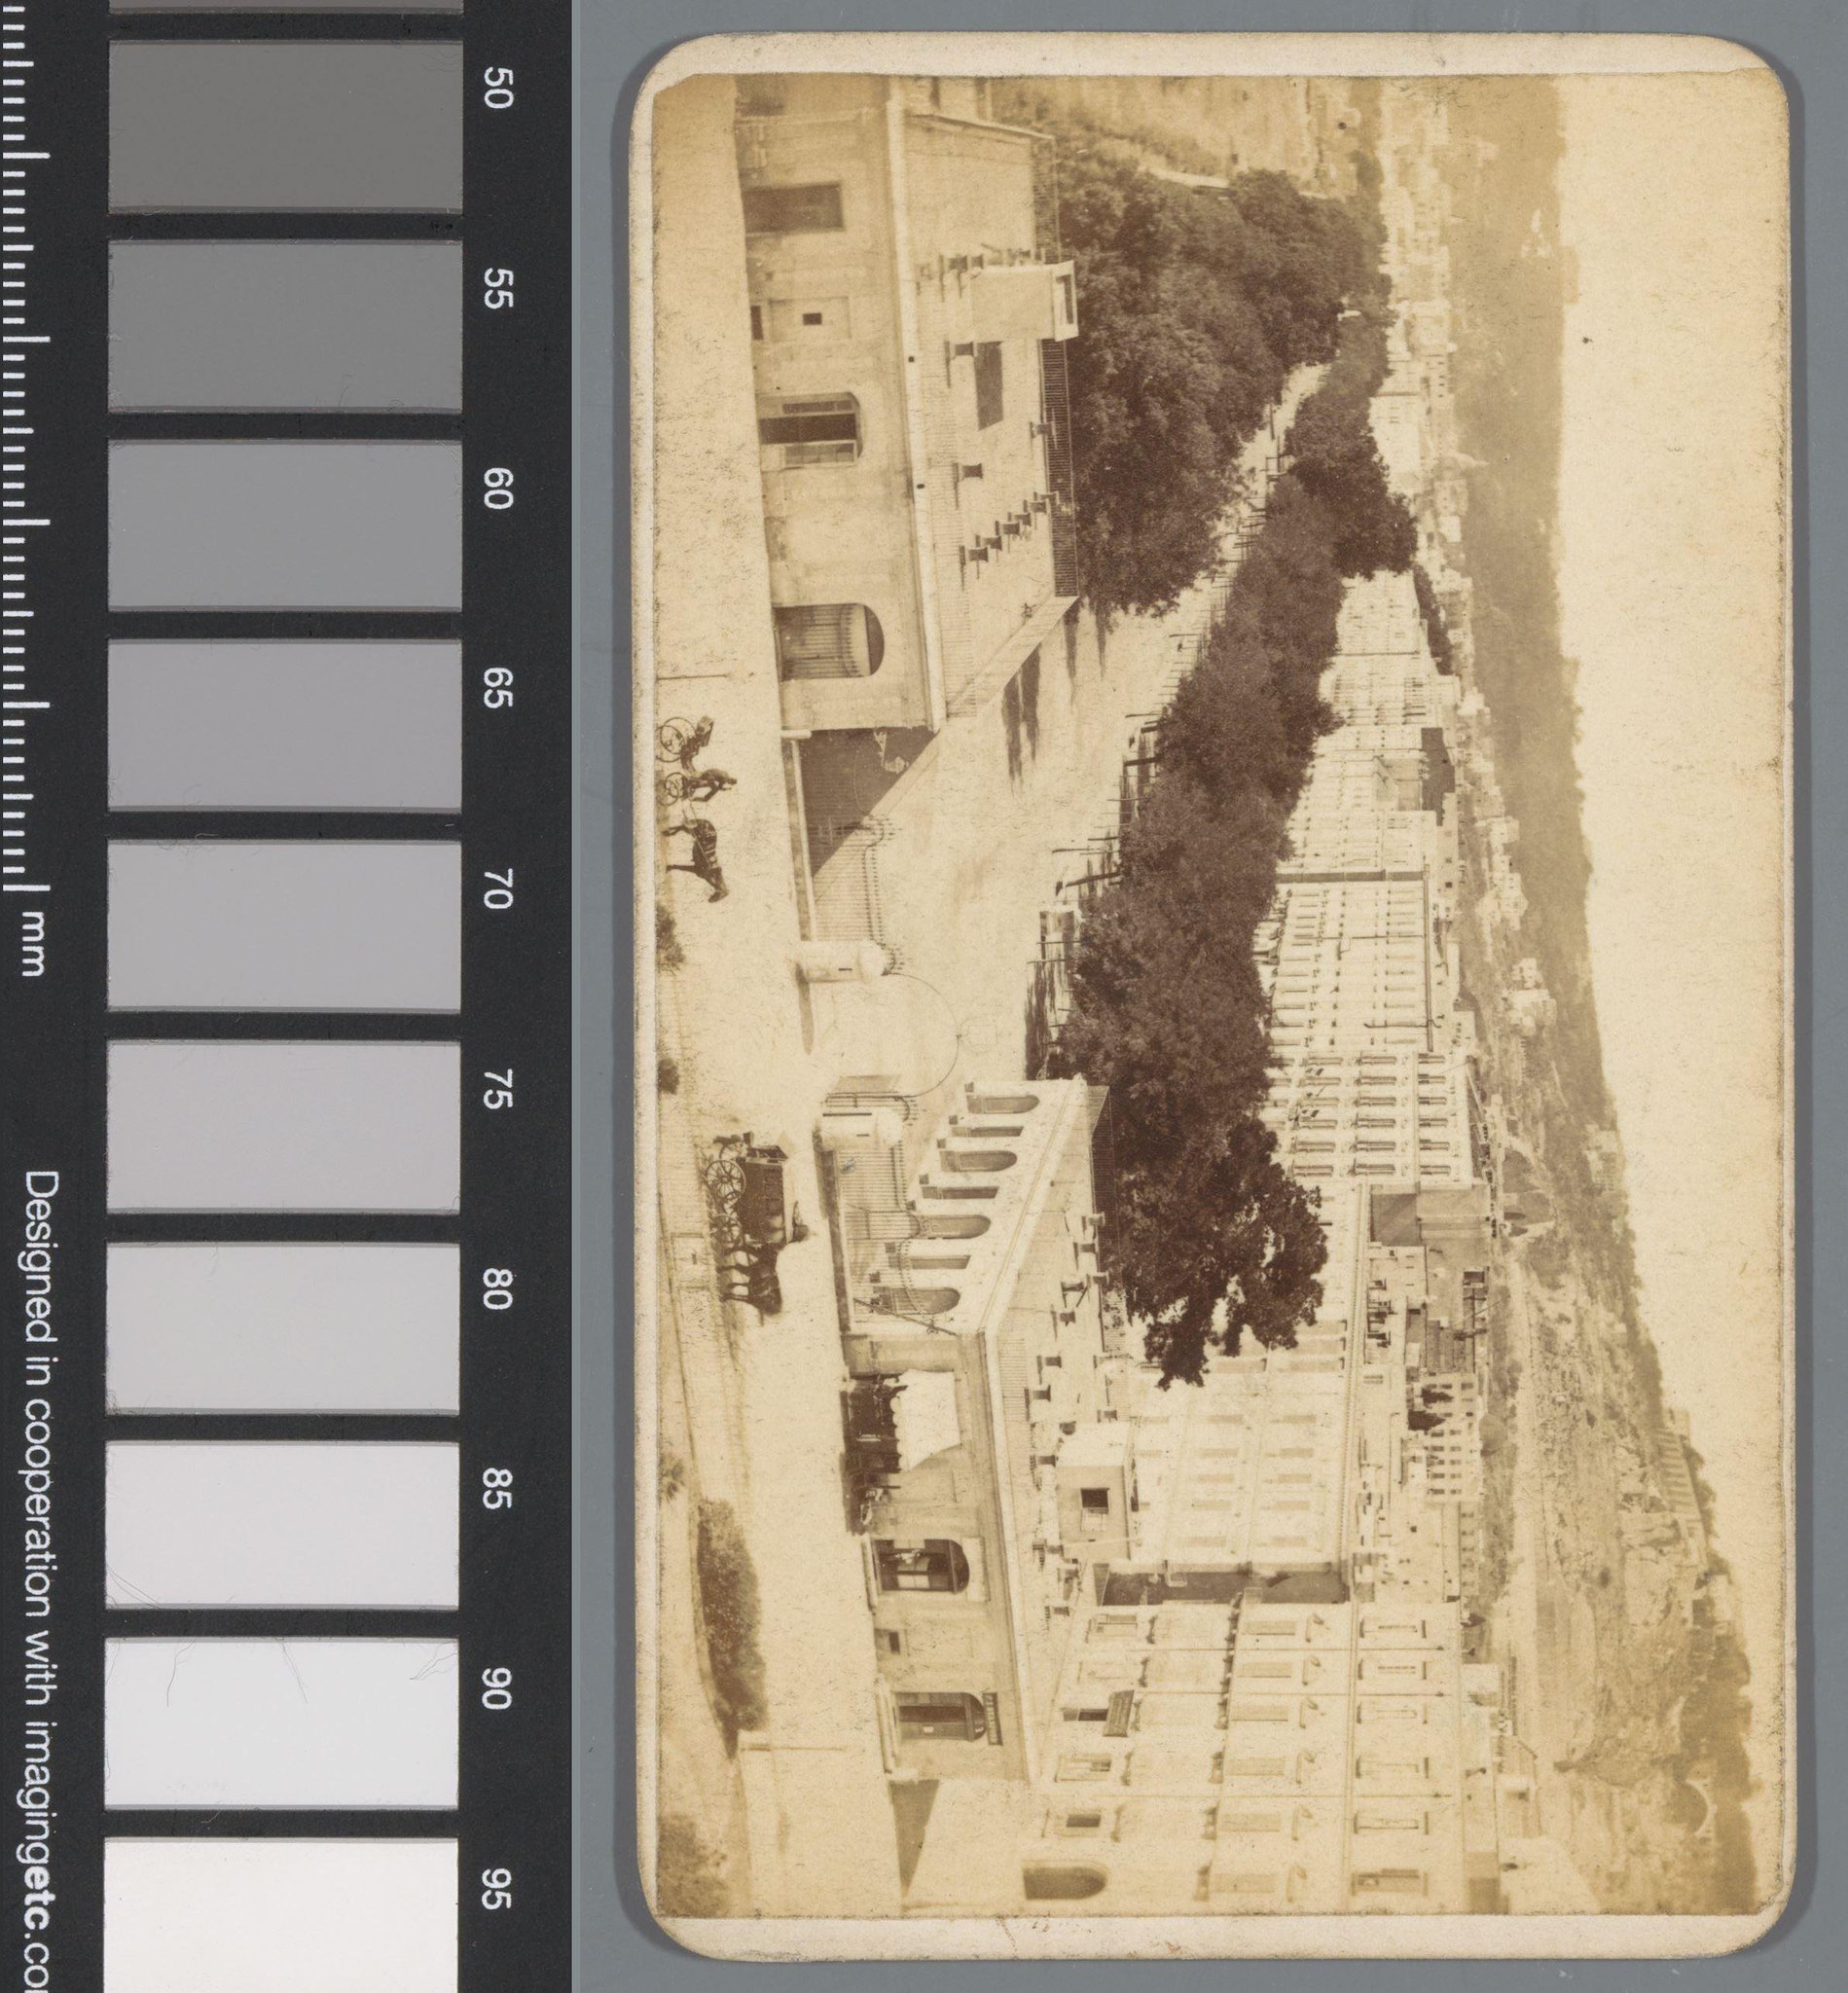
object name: carte de visite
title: Villa Reale di Napoli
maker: Anonymous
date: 1855-1885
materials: cardboard, paper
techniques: albumen print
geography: naples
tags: park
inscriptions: inscription: ‘Piazza Reale’